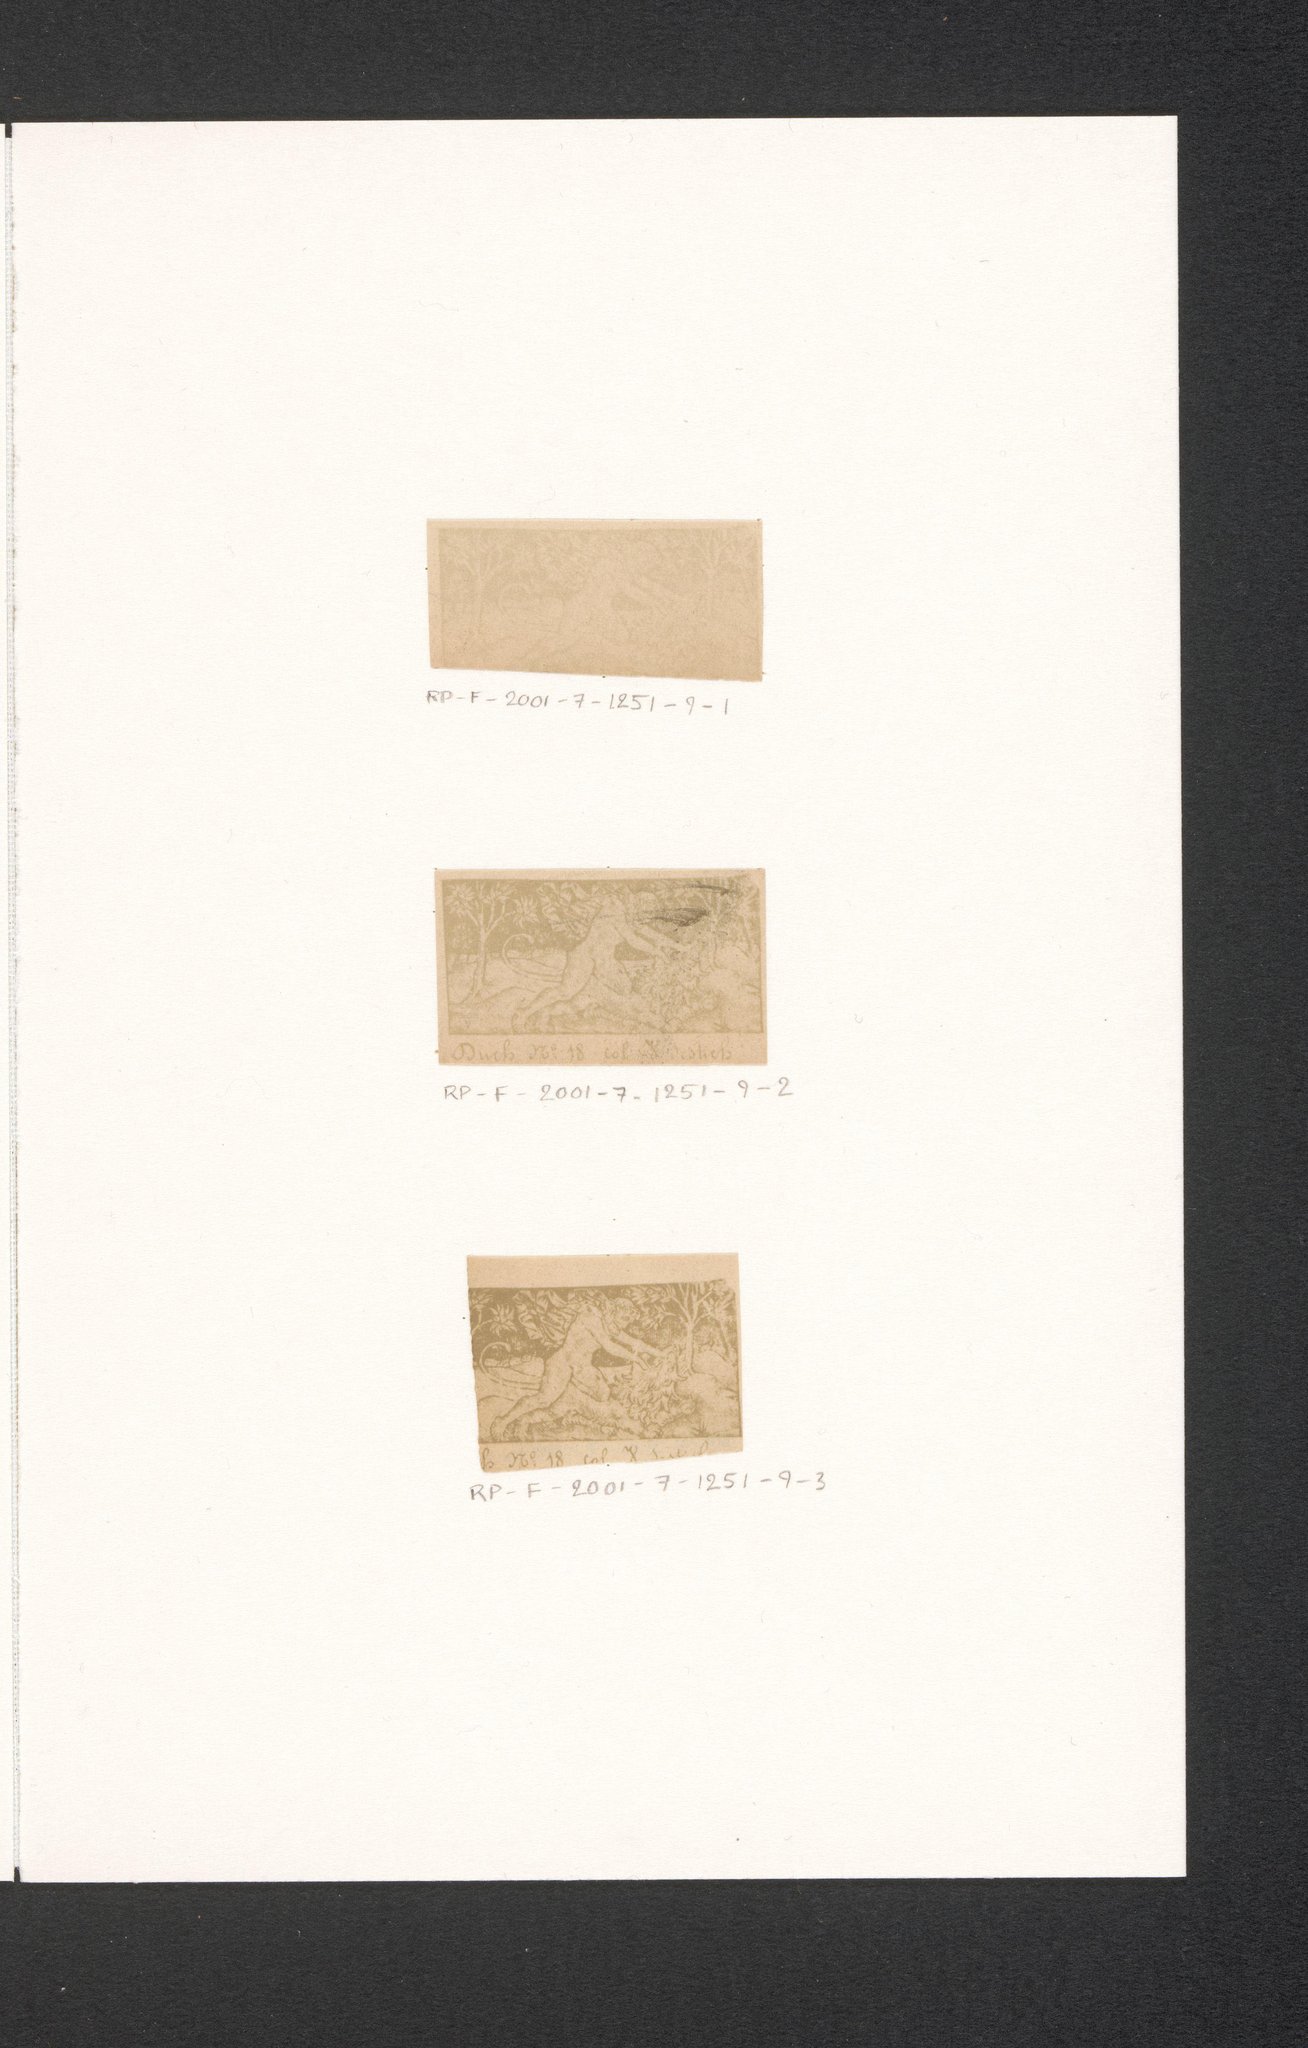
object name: reproduction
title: Fotoreproductie van een prent van Samson die een leeuw doormidden scheurt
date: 1852-1857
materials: photographic support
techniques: salted paper print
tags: samson kills the lion with his bare hands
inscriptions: inscription: ‘Duch No 18. col. [V. Se]stich’